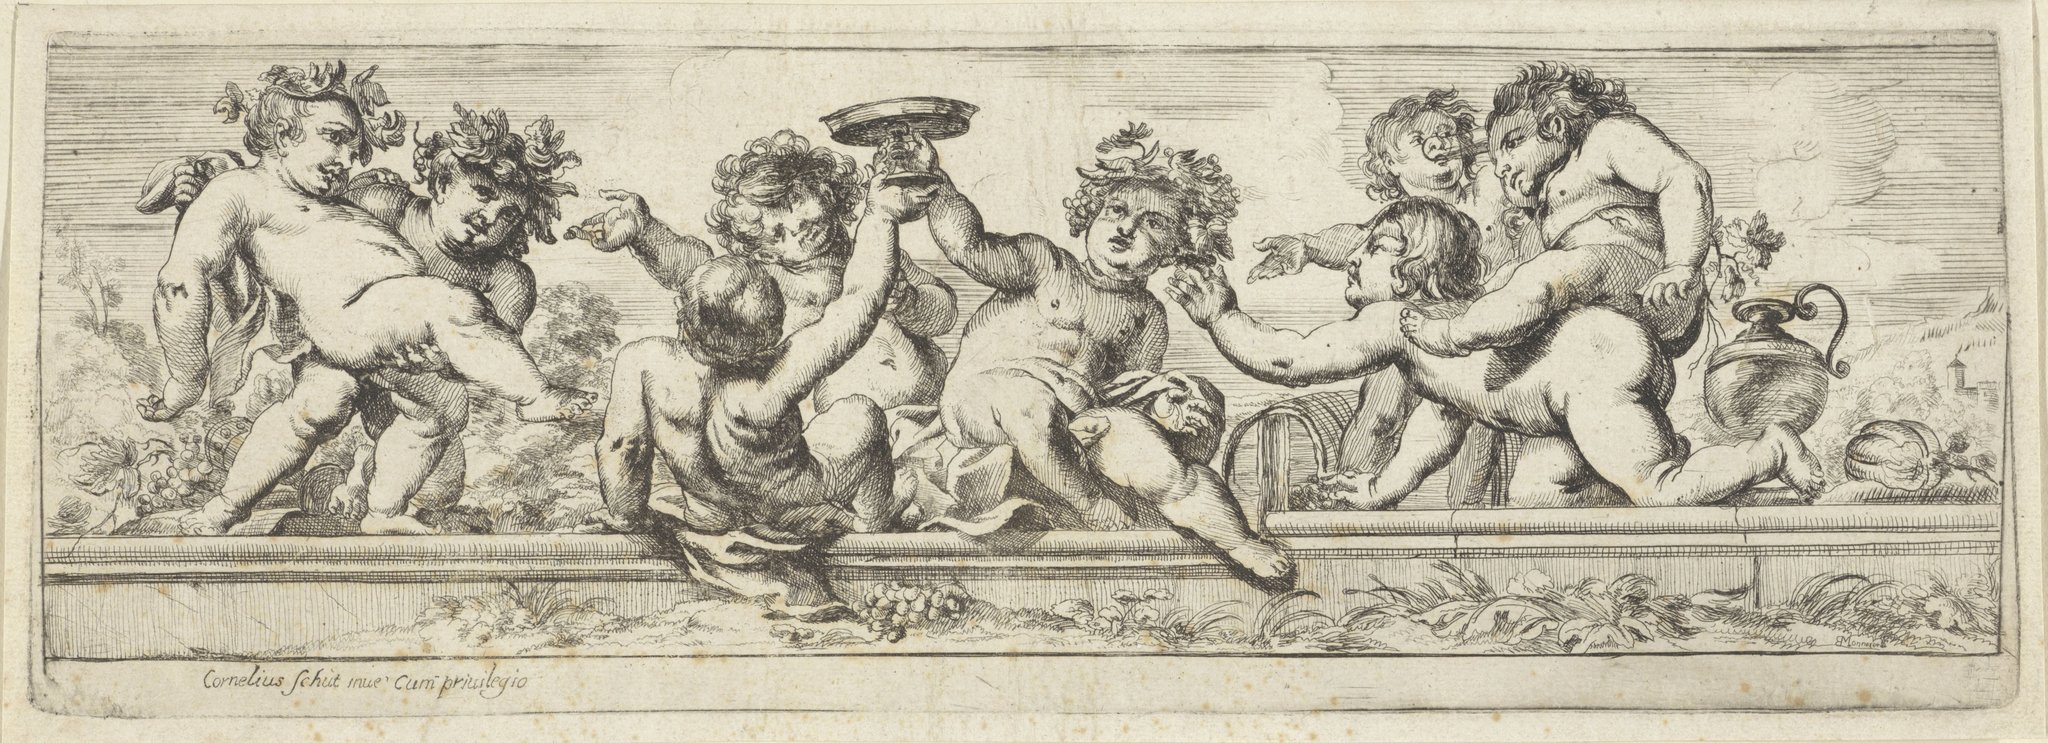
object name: print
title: Fries met acht bacchanten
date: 1618-1655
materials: paper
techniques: etching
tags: children's bacchanal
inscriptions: collector's mark: Lugt 240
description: Fries met acht dronken kinderen. Van de drie kinderen met de drinkschaal in het midden stelt het kind rechts Bacchus voor. Op de achtergrond een wijnvat.